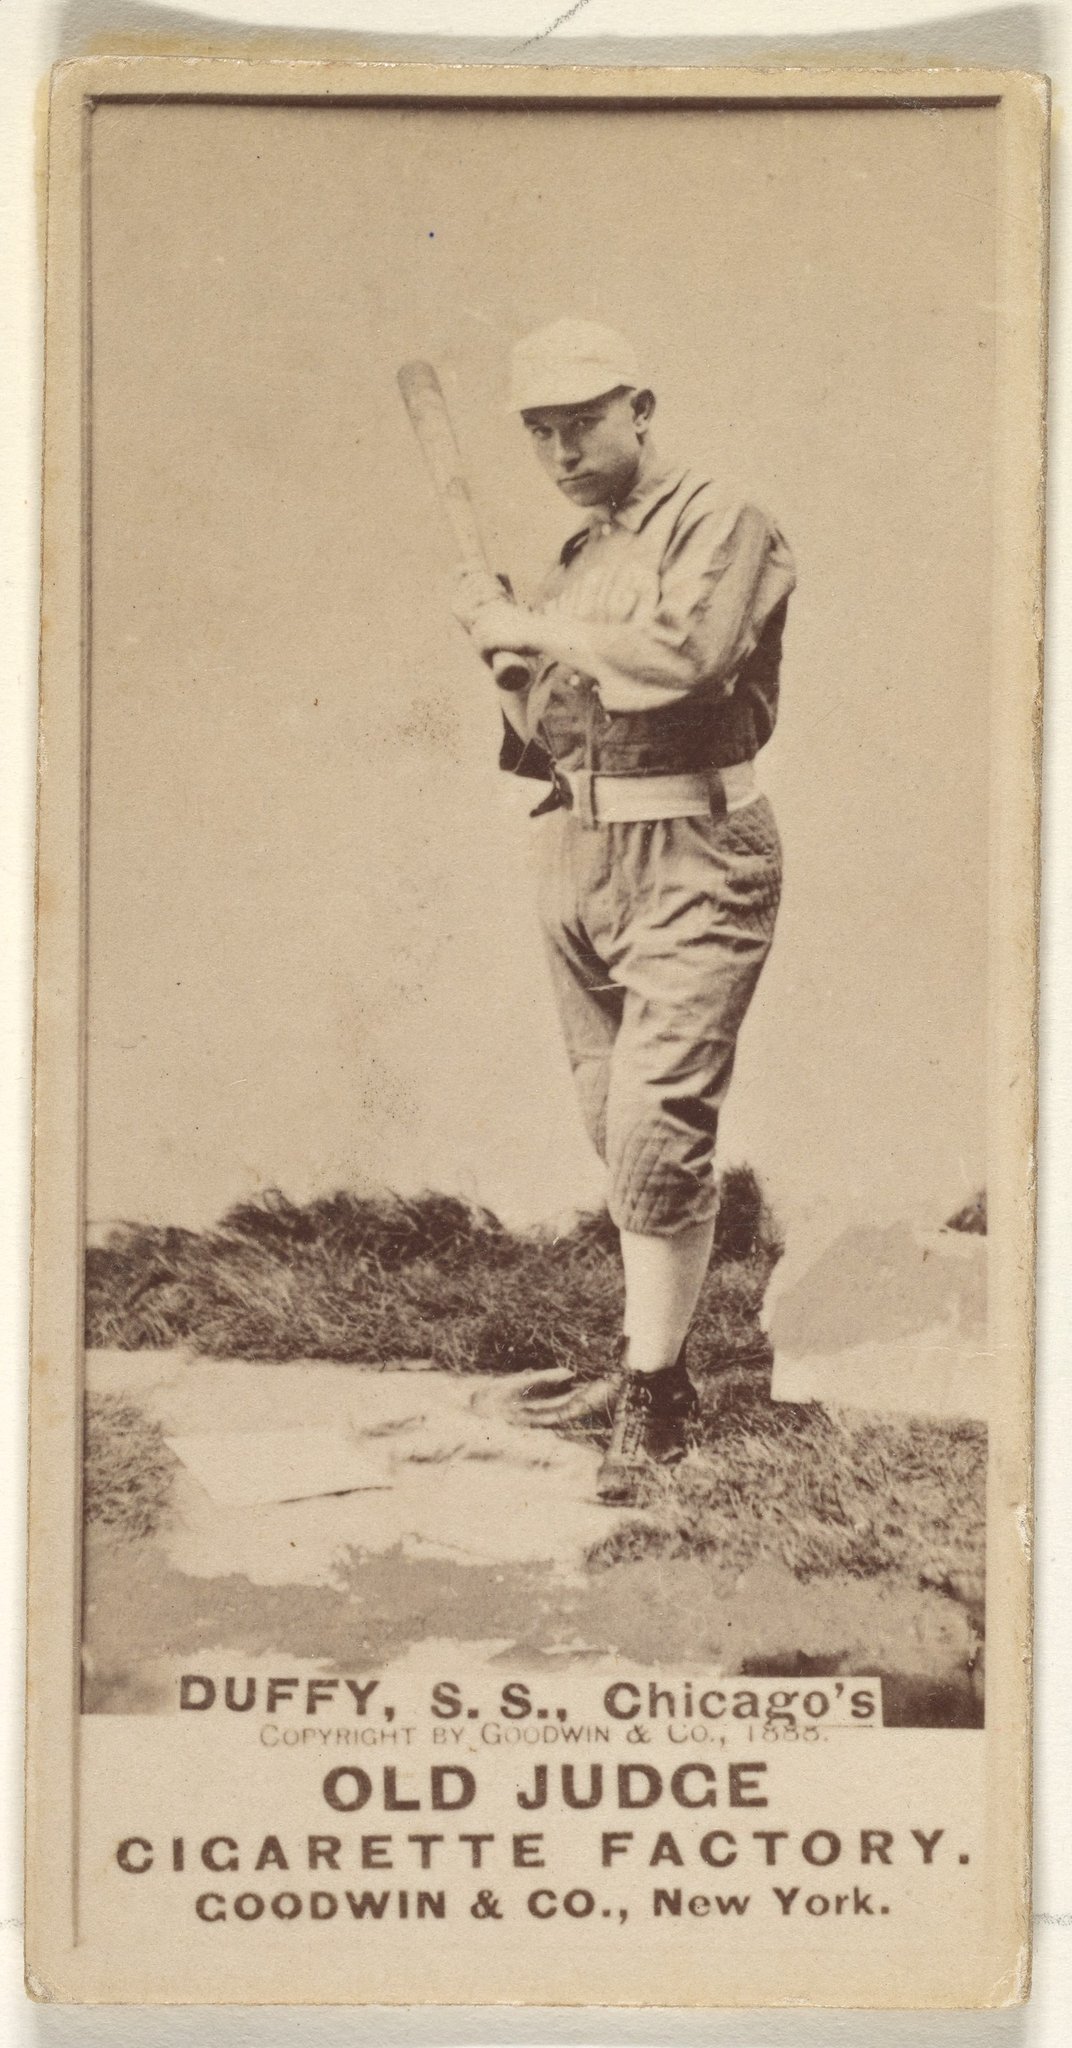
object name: baseball card, photograph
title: Hugh Duffy, Shortstop, Chicago, from the Old Judge series (N172) for Old Judge Cigarettes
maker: goodwin & company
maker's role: publisher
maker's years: 1850-1950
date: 1888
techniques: albumen silver print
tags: men,portraits,baseball,athletes